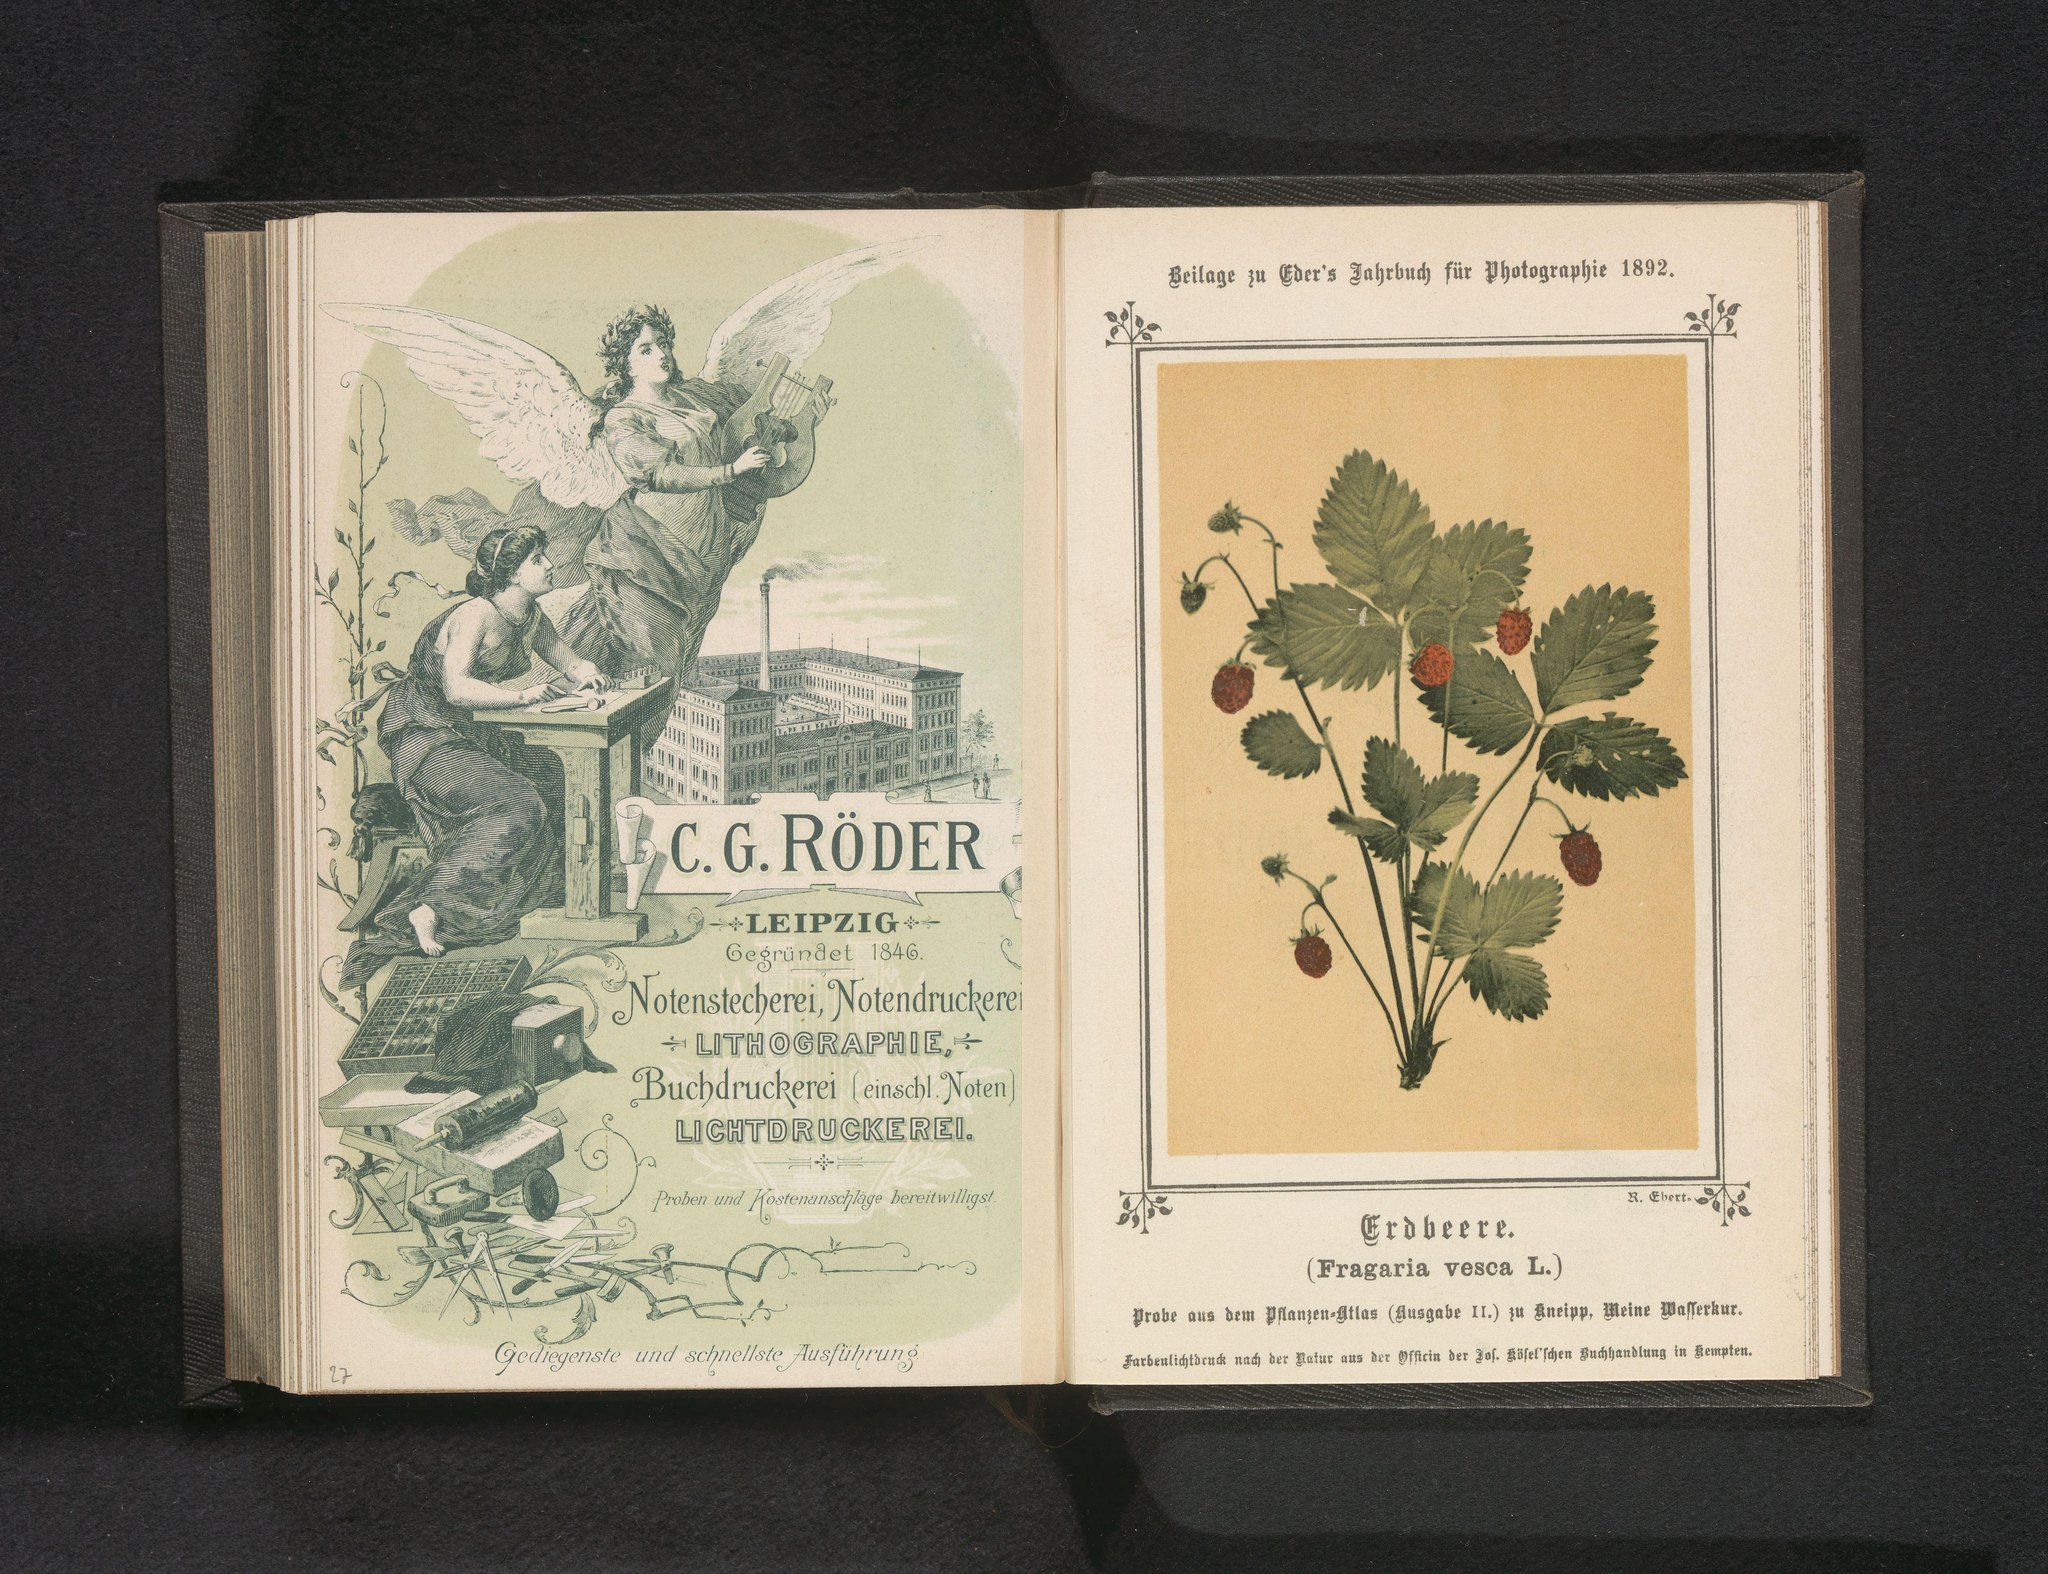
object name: reproduction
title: Reproductie van een tekening van een aardbeienplant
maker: Anonymous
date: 1887-1892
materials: paper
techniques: chromolithography, photograph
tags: plants and herbs: strawberry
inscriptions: inscription: ‘R. Ebert/ Erdbeere./ (Fragaria vesca L.) (...)’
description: Prent op vijfenvijftigste ongenummerde pagina na pagina 520.